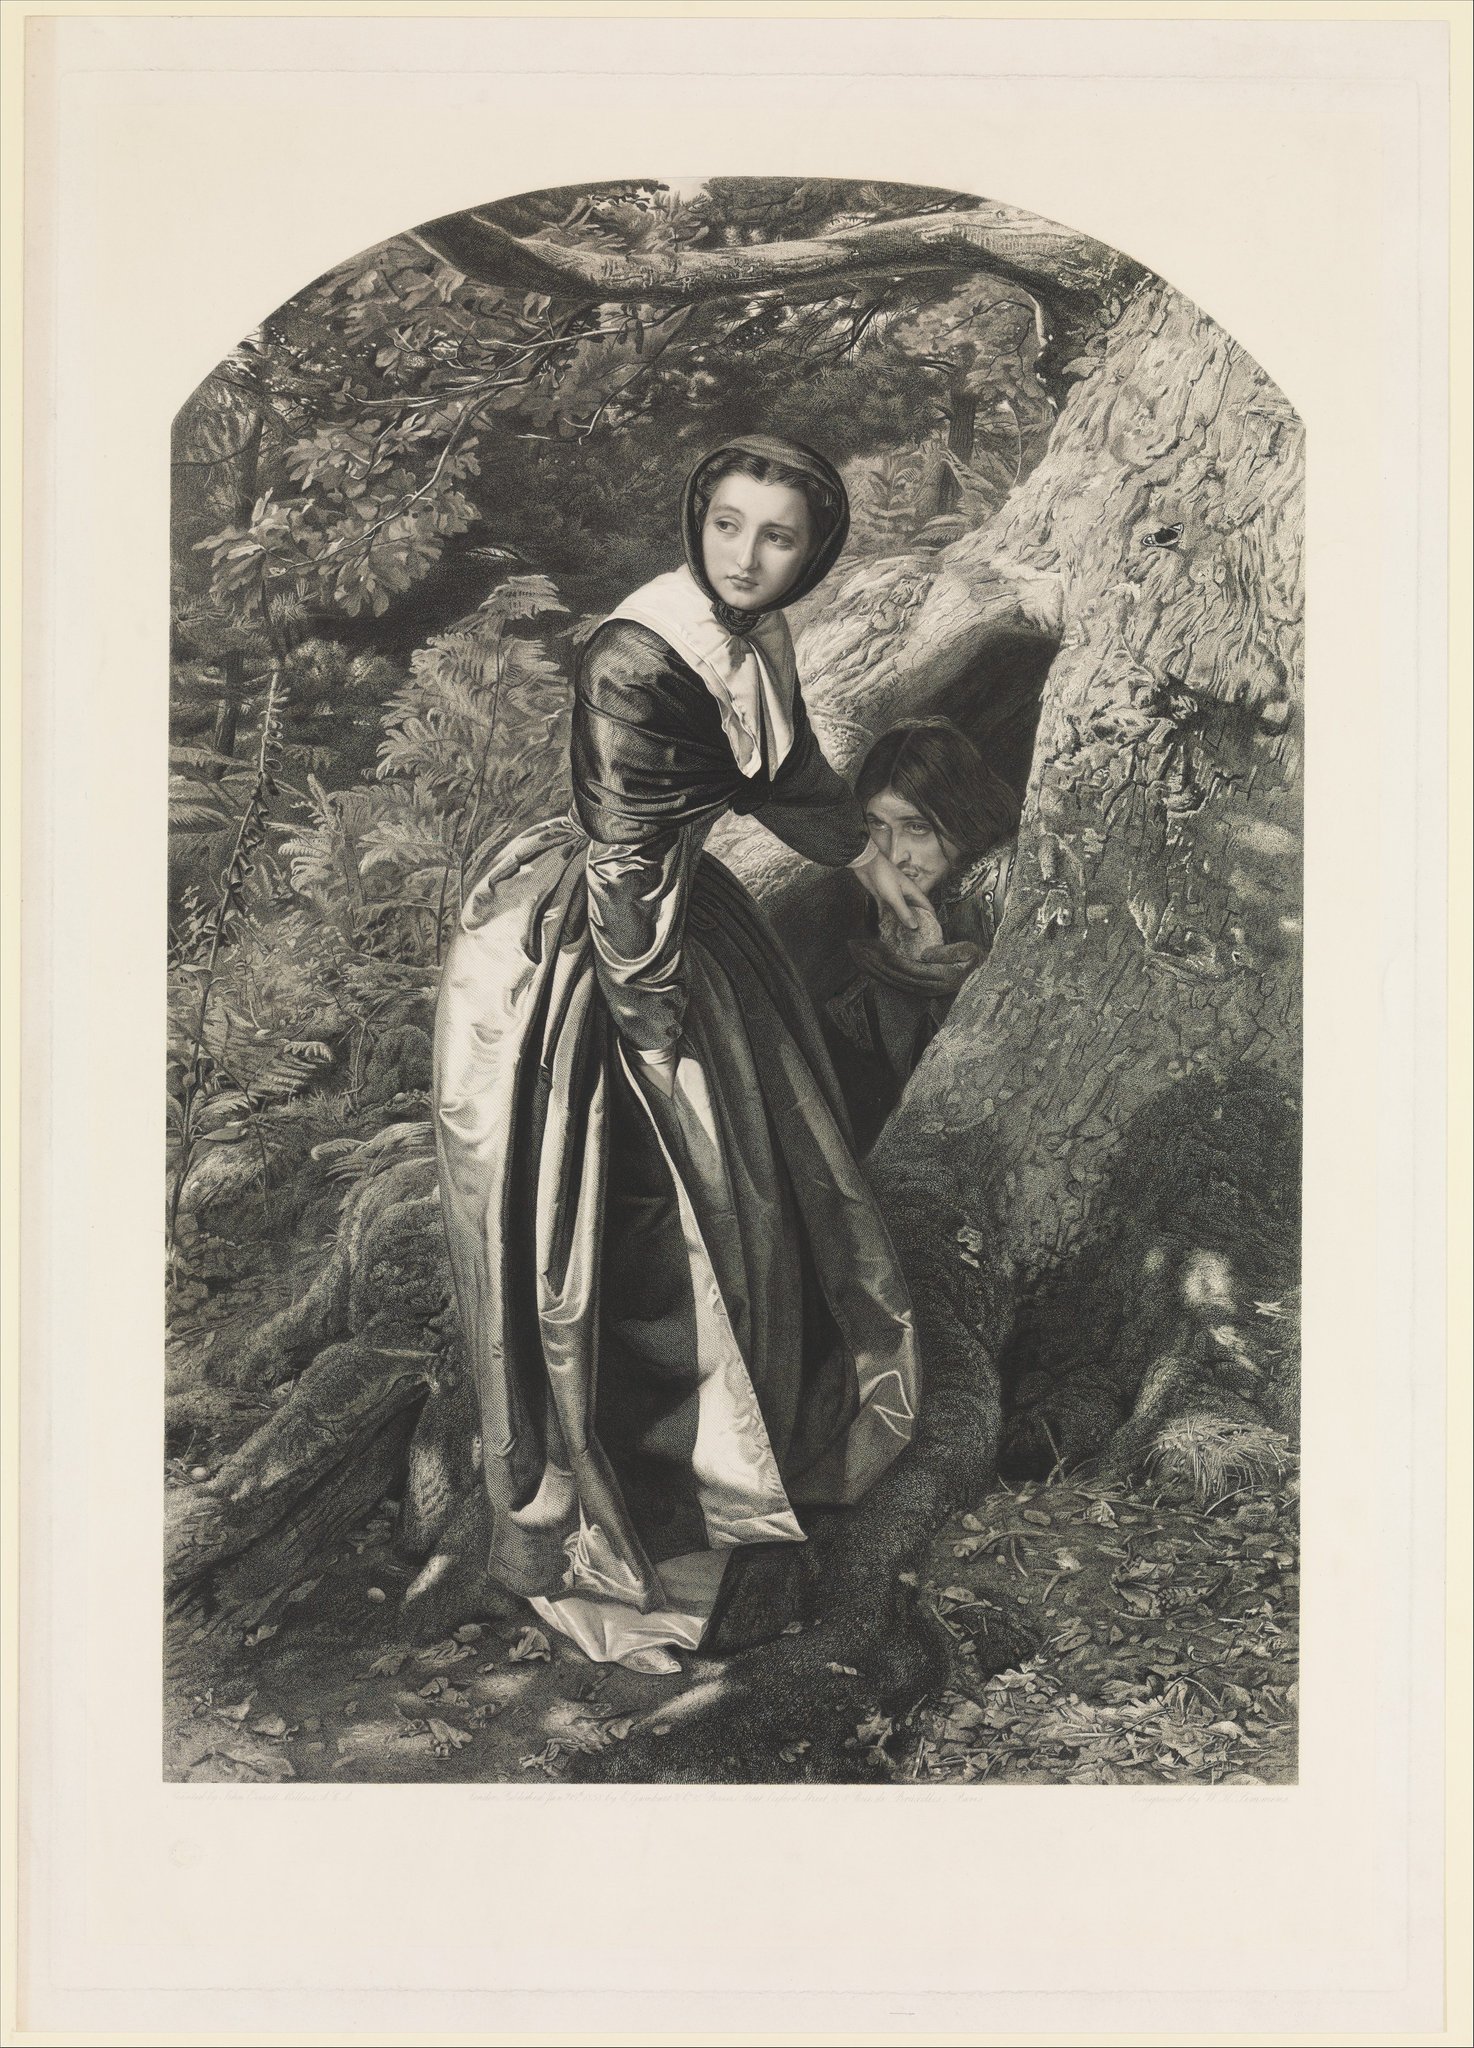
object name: print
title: The Proscribed Royalist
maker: william henry simmons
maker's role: engraver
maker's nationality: british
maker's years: 1811-1882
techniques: printmaking, engraving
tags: men,women,trees